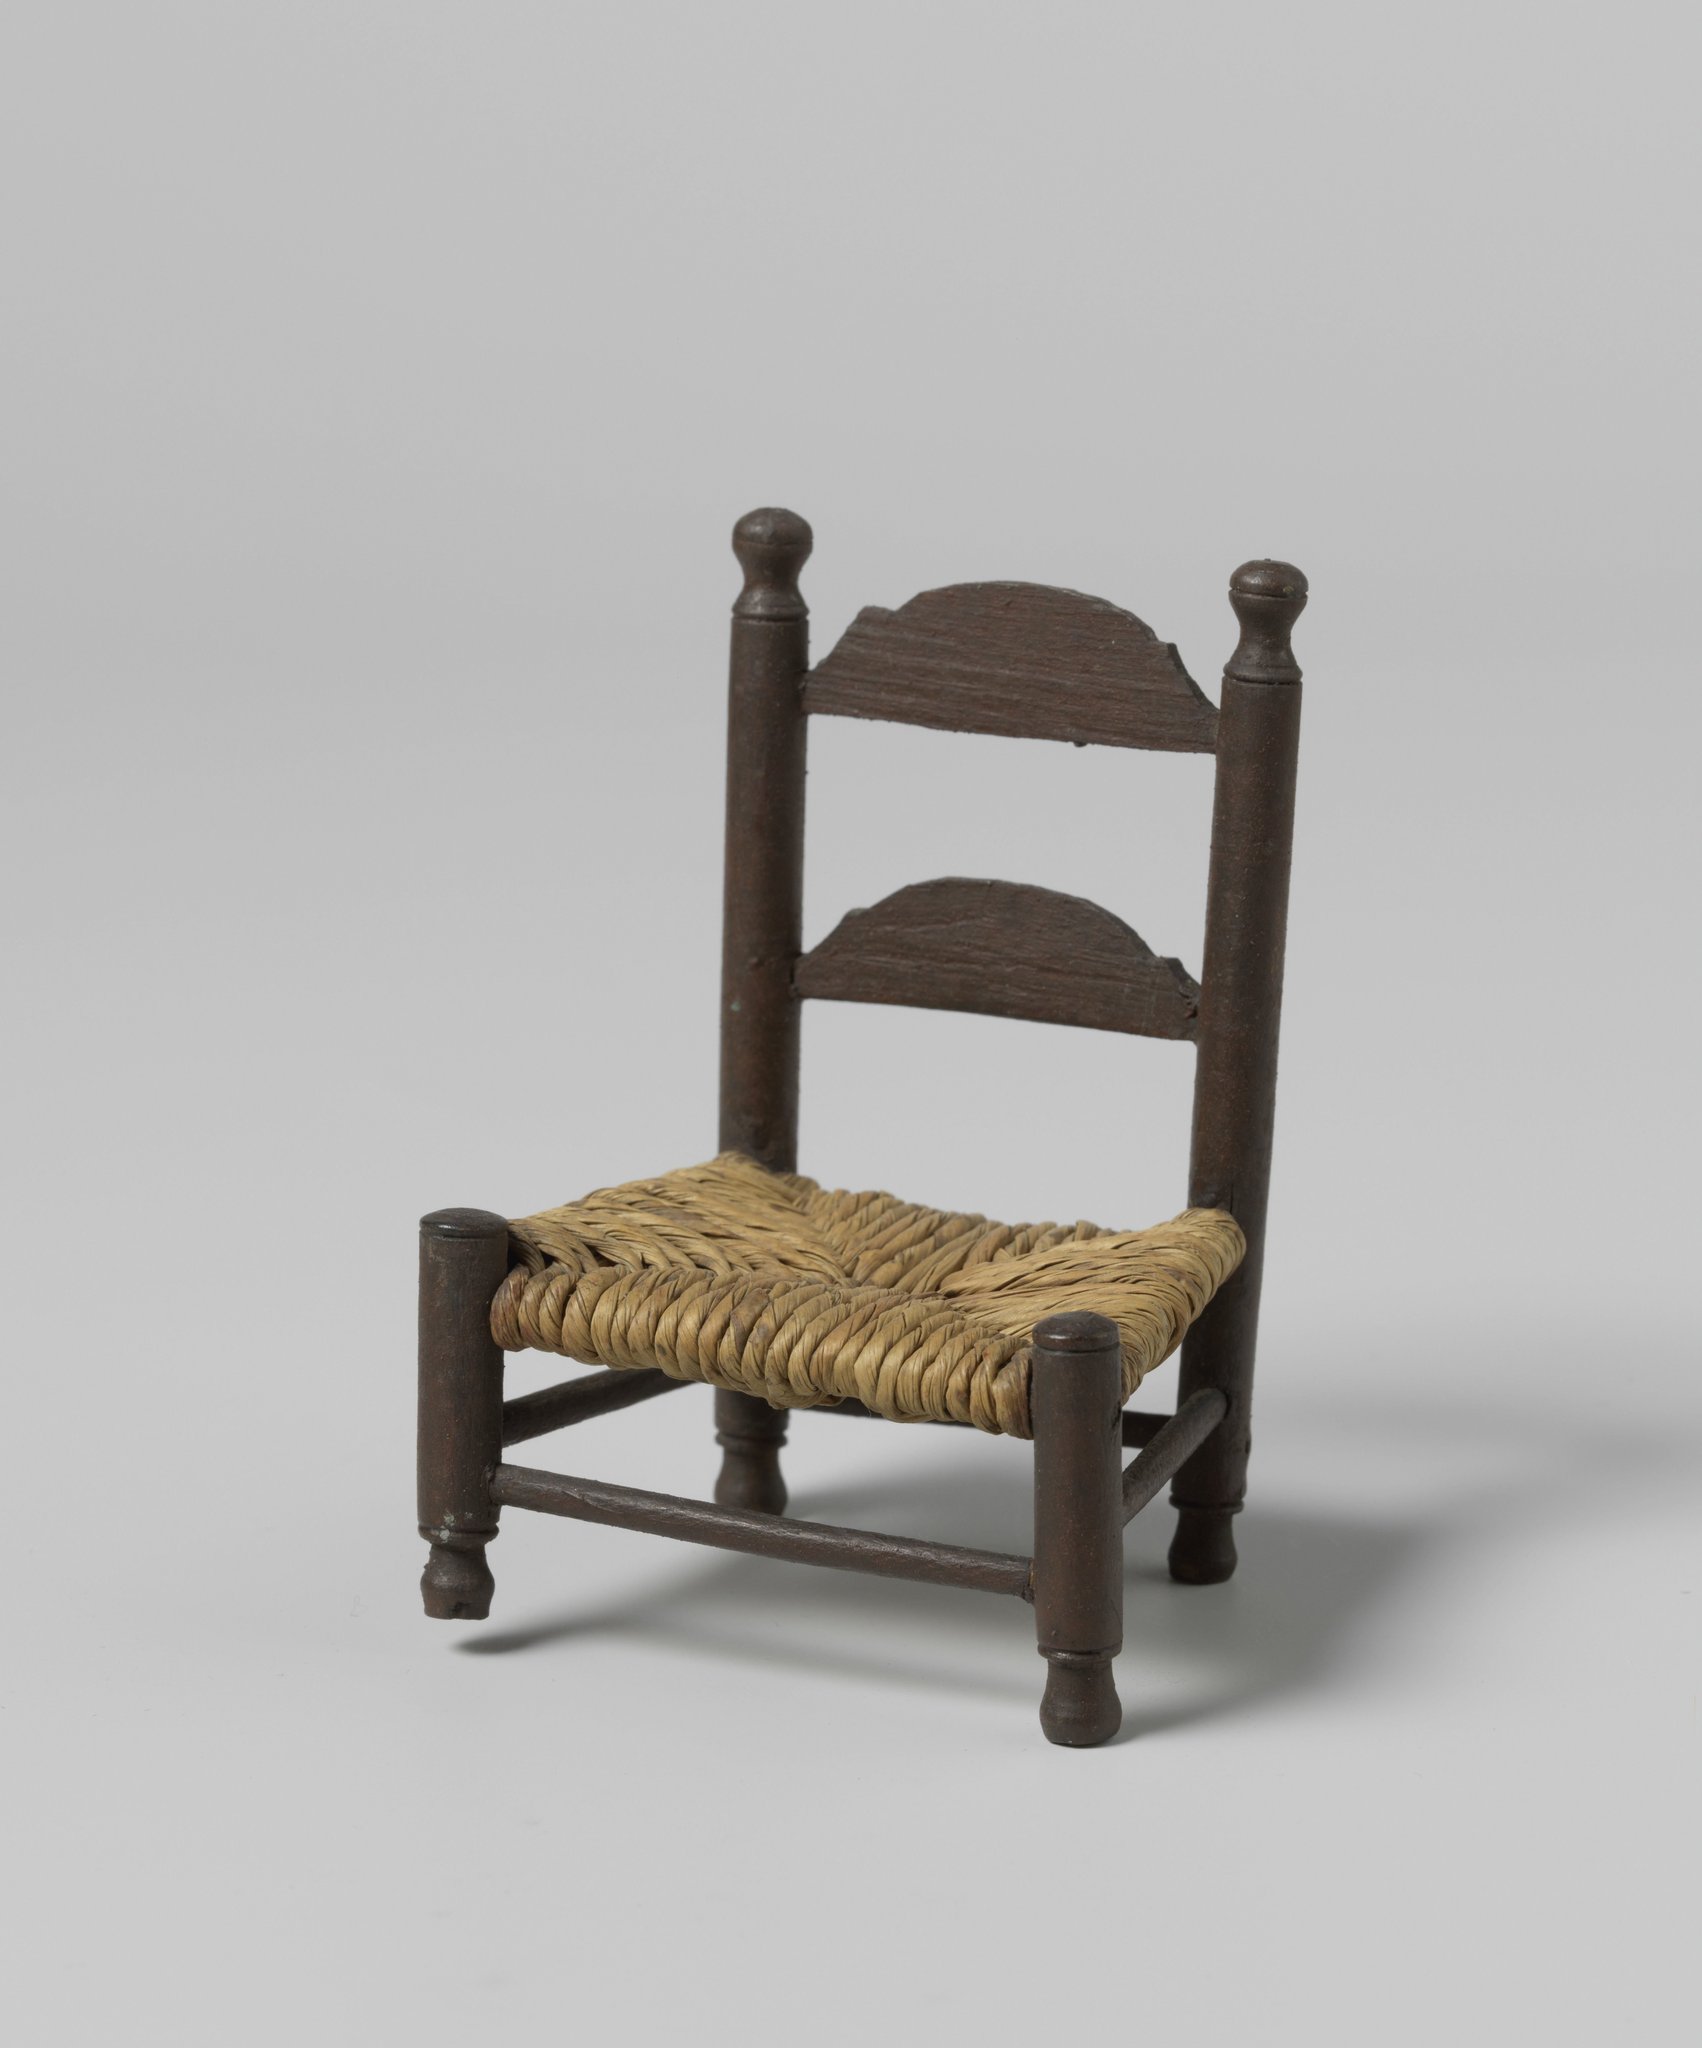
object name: knopstoel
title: Knopstoel, de rugleuning met twee dwarsregels, de zitting van gevlochten biezen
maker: Anonymous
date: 1750-1760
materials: fiber, wood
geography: amsterdam